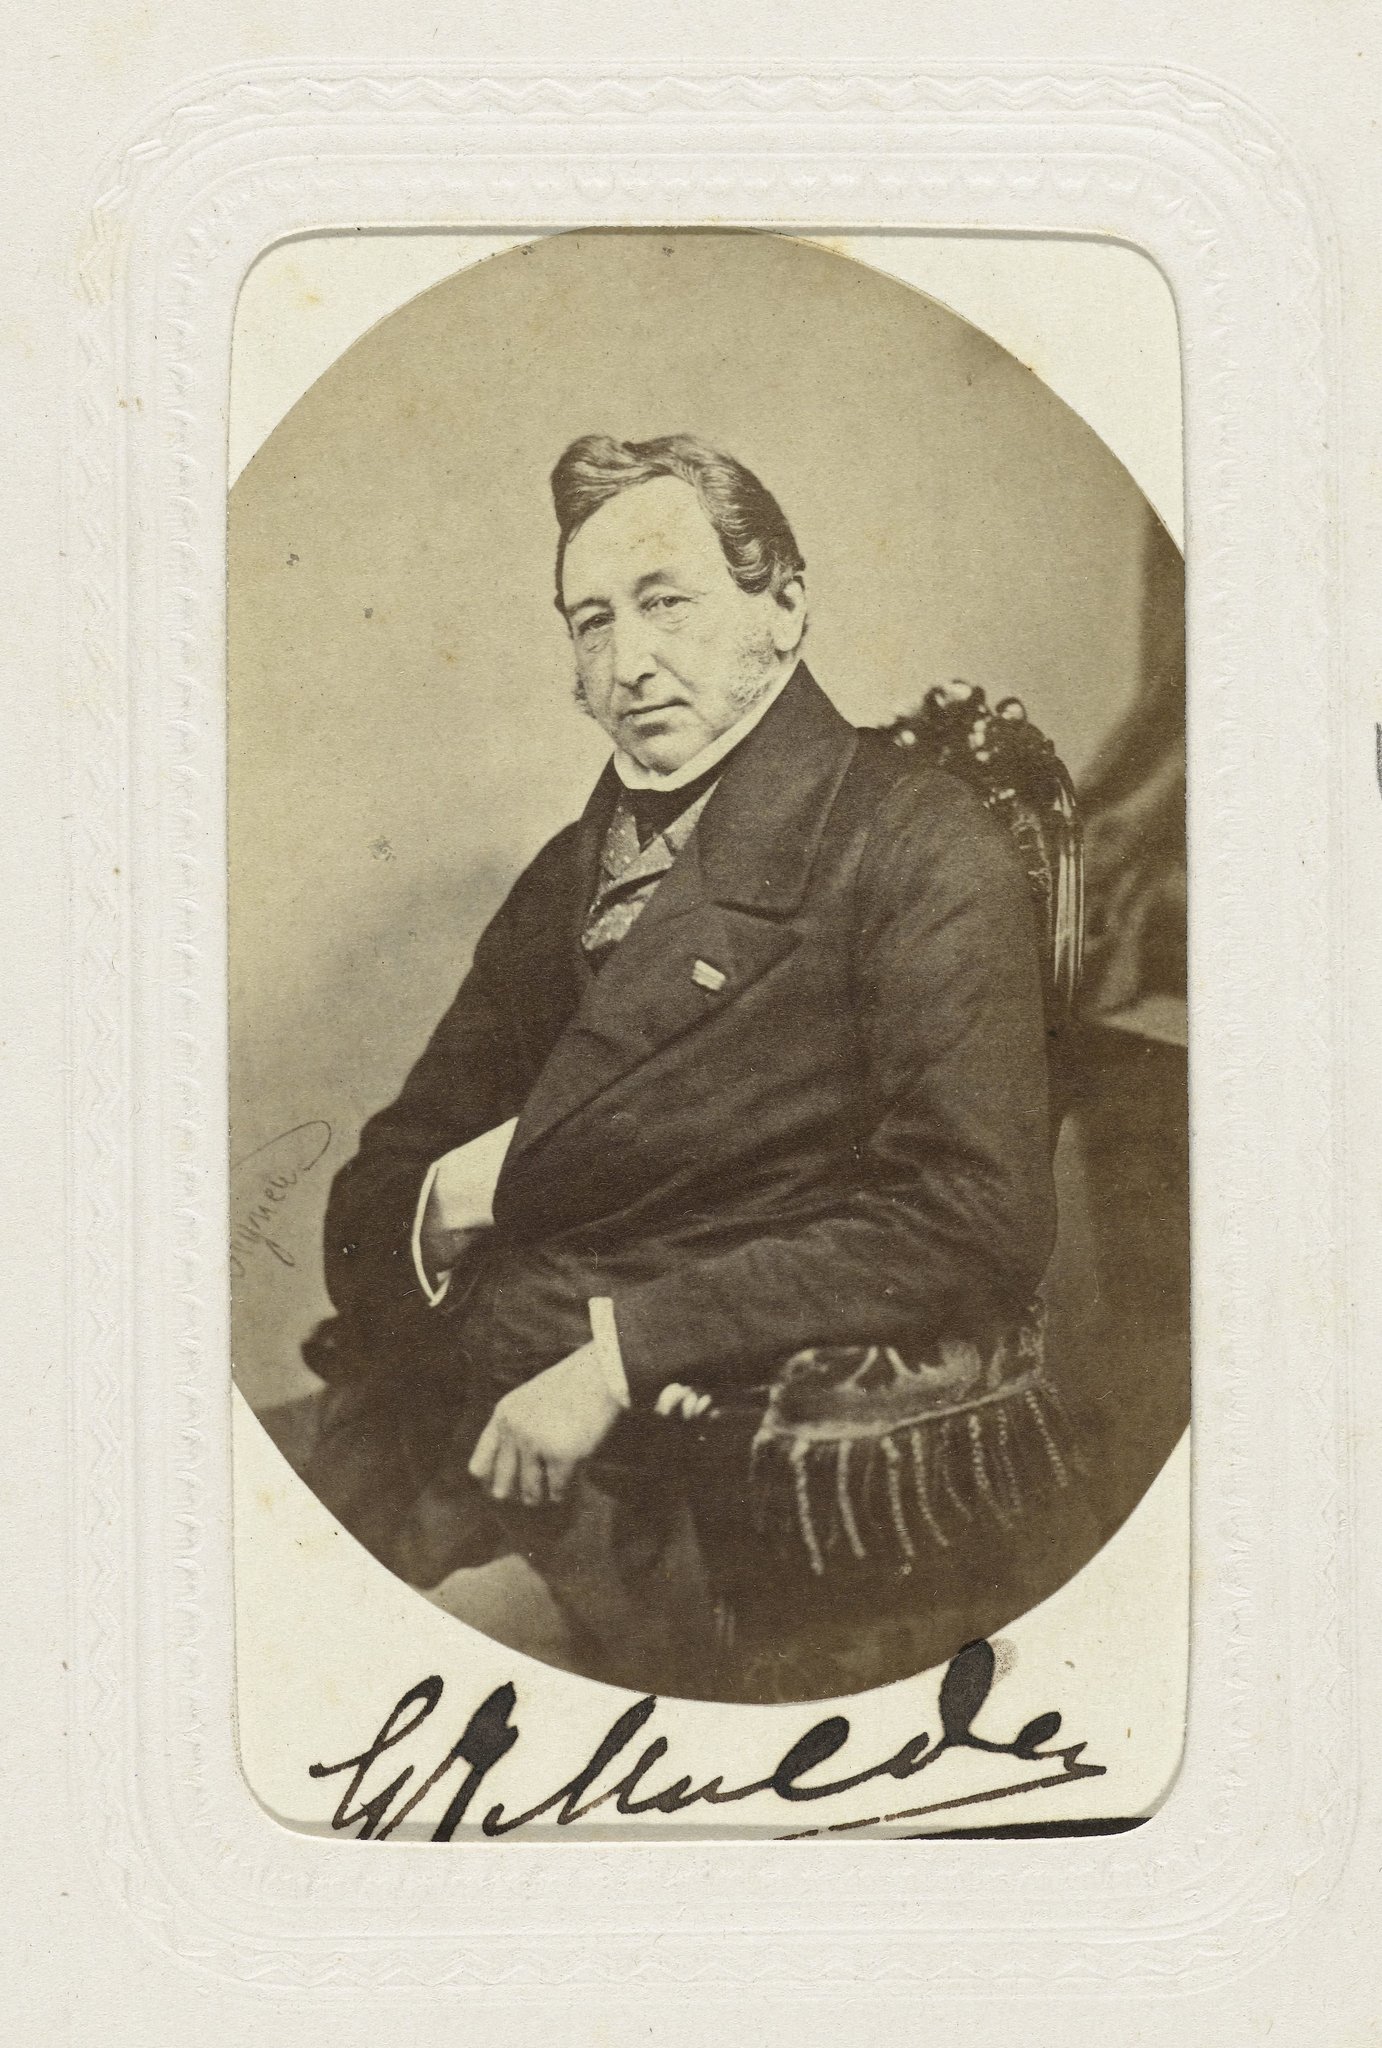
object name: carte de visite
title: Portret van G.J. Mulder, hoogleraar in de faculteit Wis- en Natuurkunde aan de universiteit van Utrecht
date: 1863-1866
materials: cardboard, paper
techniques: albumen print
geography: utrecht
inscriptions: signature: ‘G.J. Mulder’